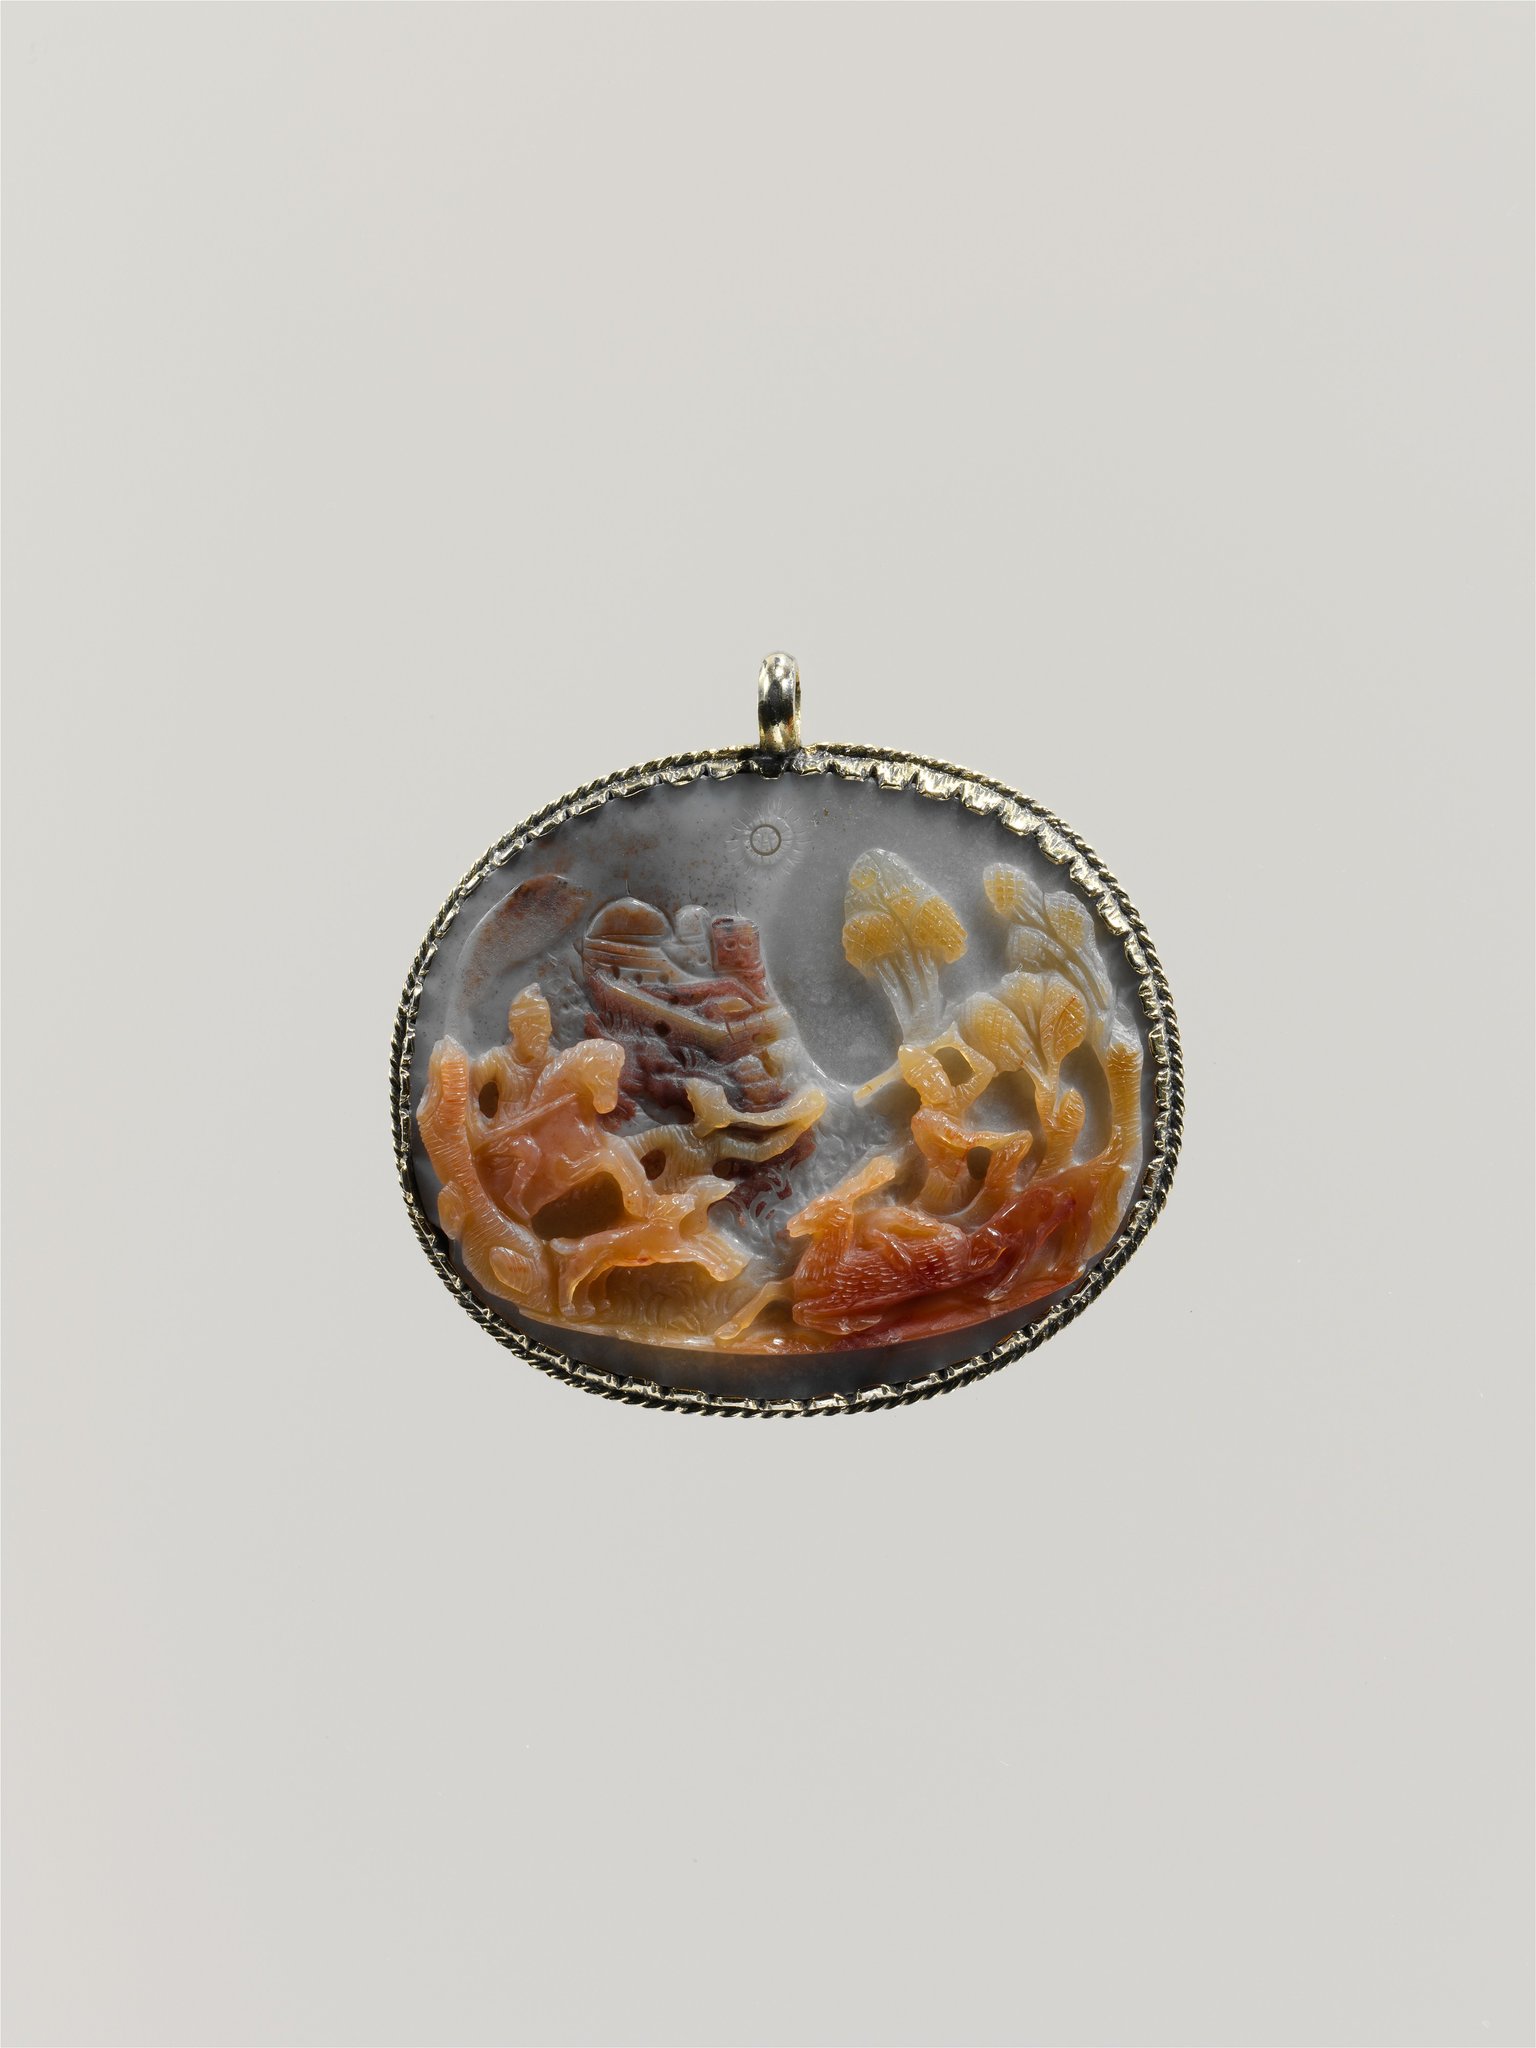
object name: cameo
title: Hunt of a roebuck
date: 1567-1600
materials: stone, silver gilt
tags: horses